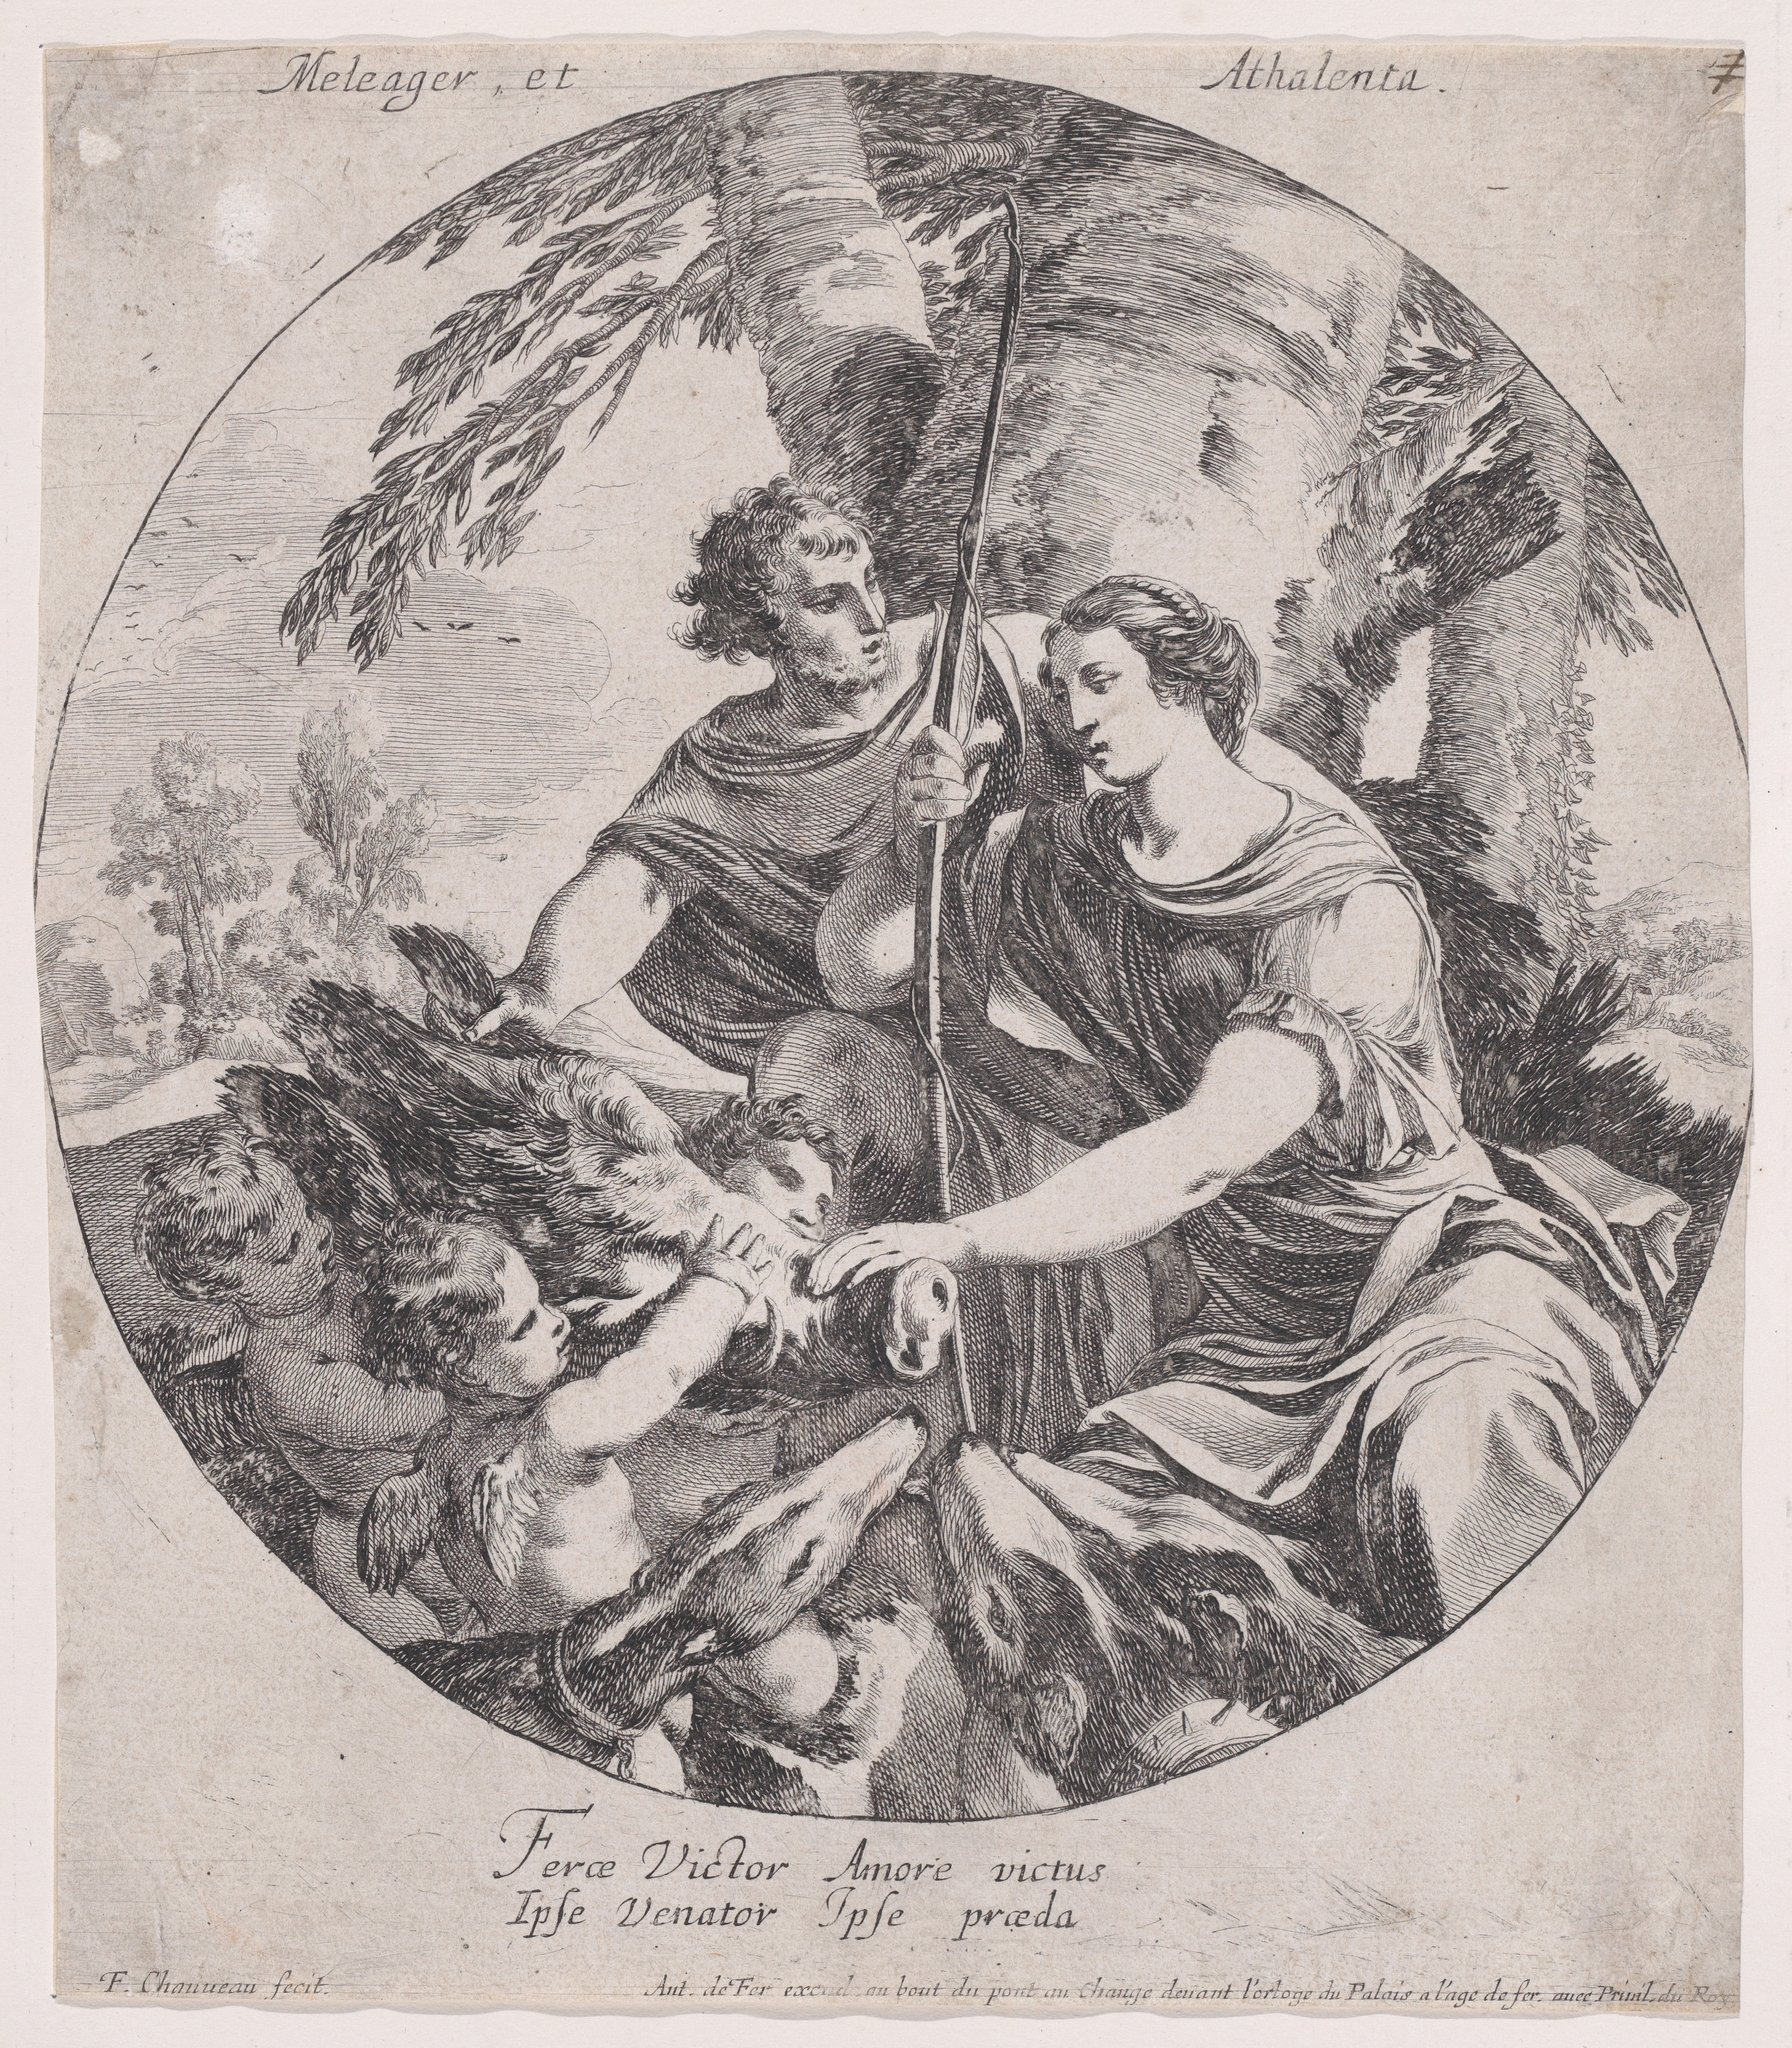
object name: print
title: Meleager and Atalanta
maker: françois chauveau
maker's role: artist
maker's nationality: french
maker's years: 1613-1676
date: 1643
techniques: engraving, etching